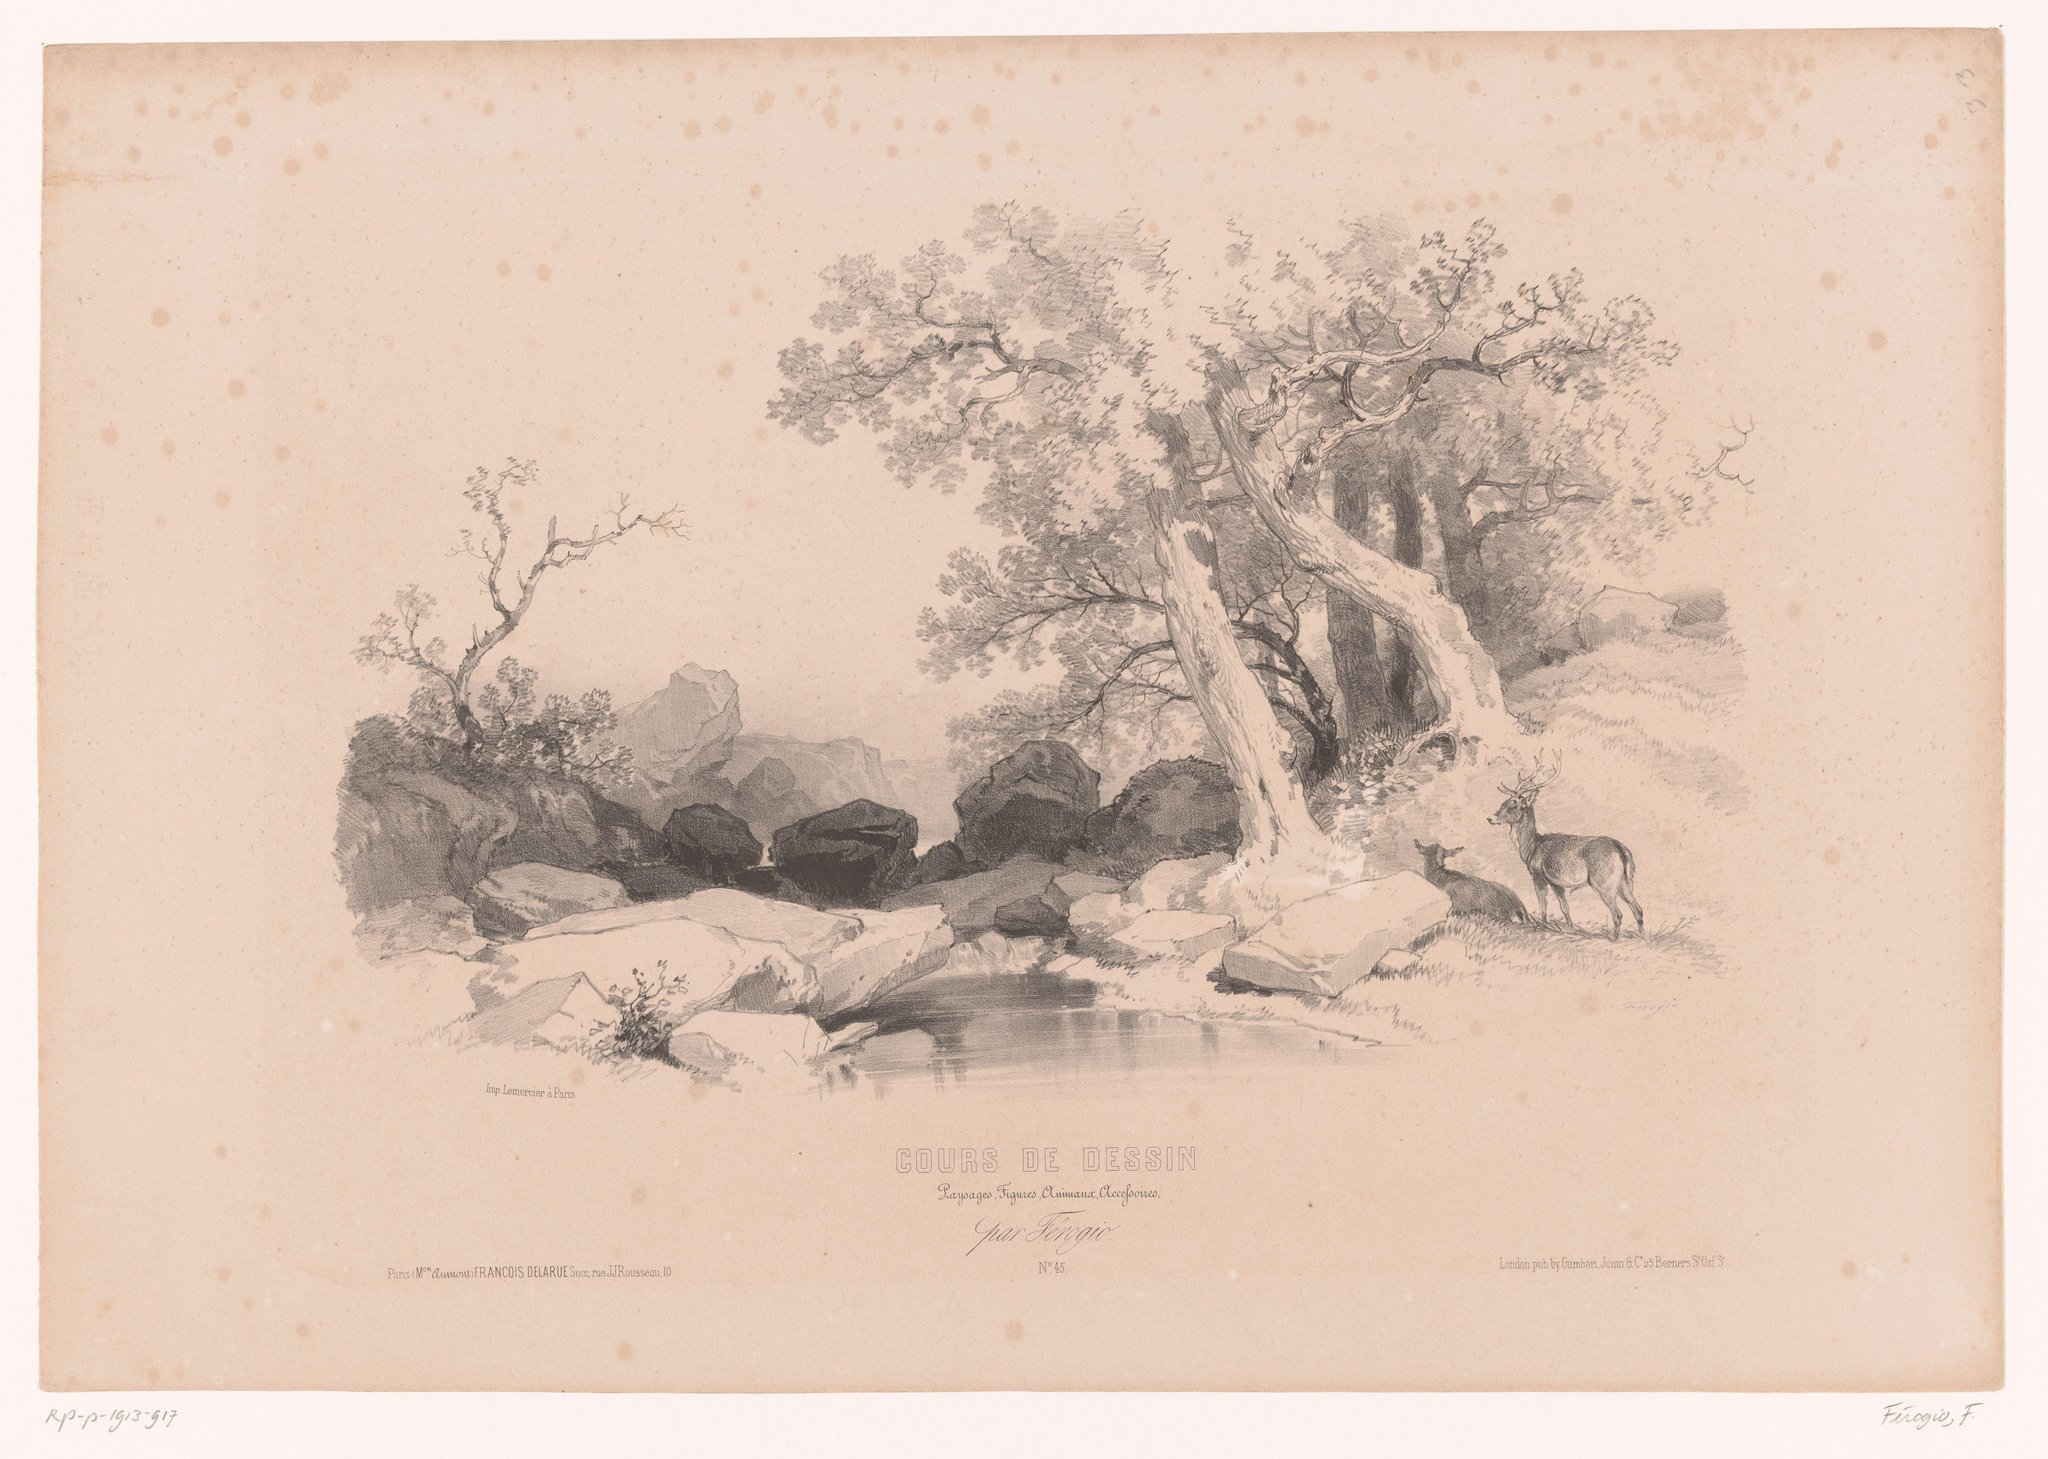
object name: print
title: Cours de dessin. Paysages, figures, animaux, accessoires, par Férogio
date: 1845-1846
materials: paper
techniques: lithograph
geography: paris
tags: hoofed animals: stag, pond, pool, rocks (+ landscape with figures, staffage)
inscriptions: collector's mark: Lugt 2228a